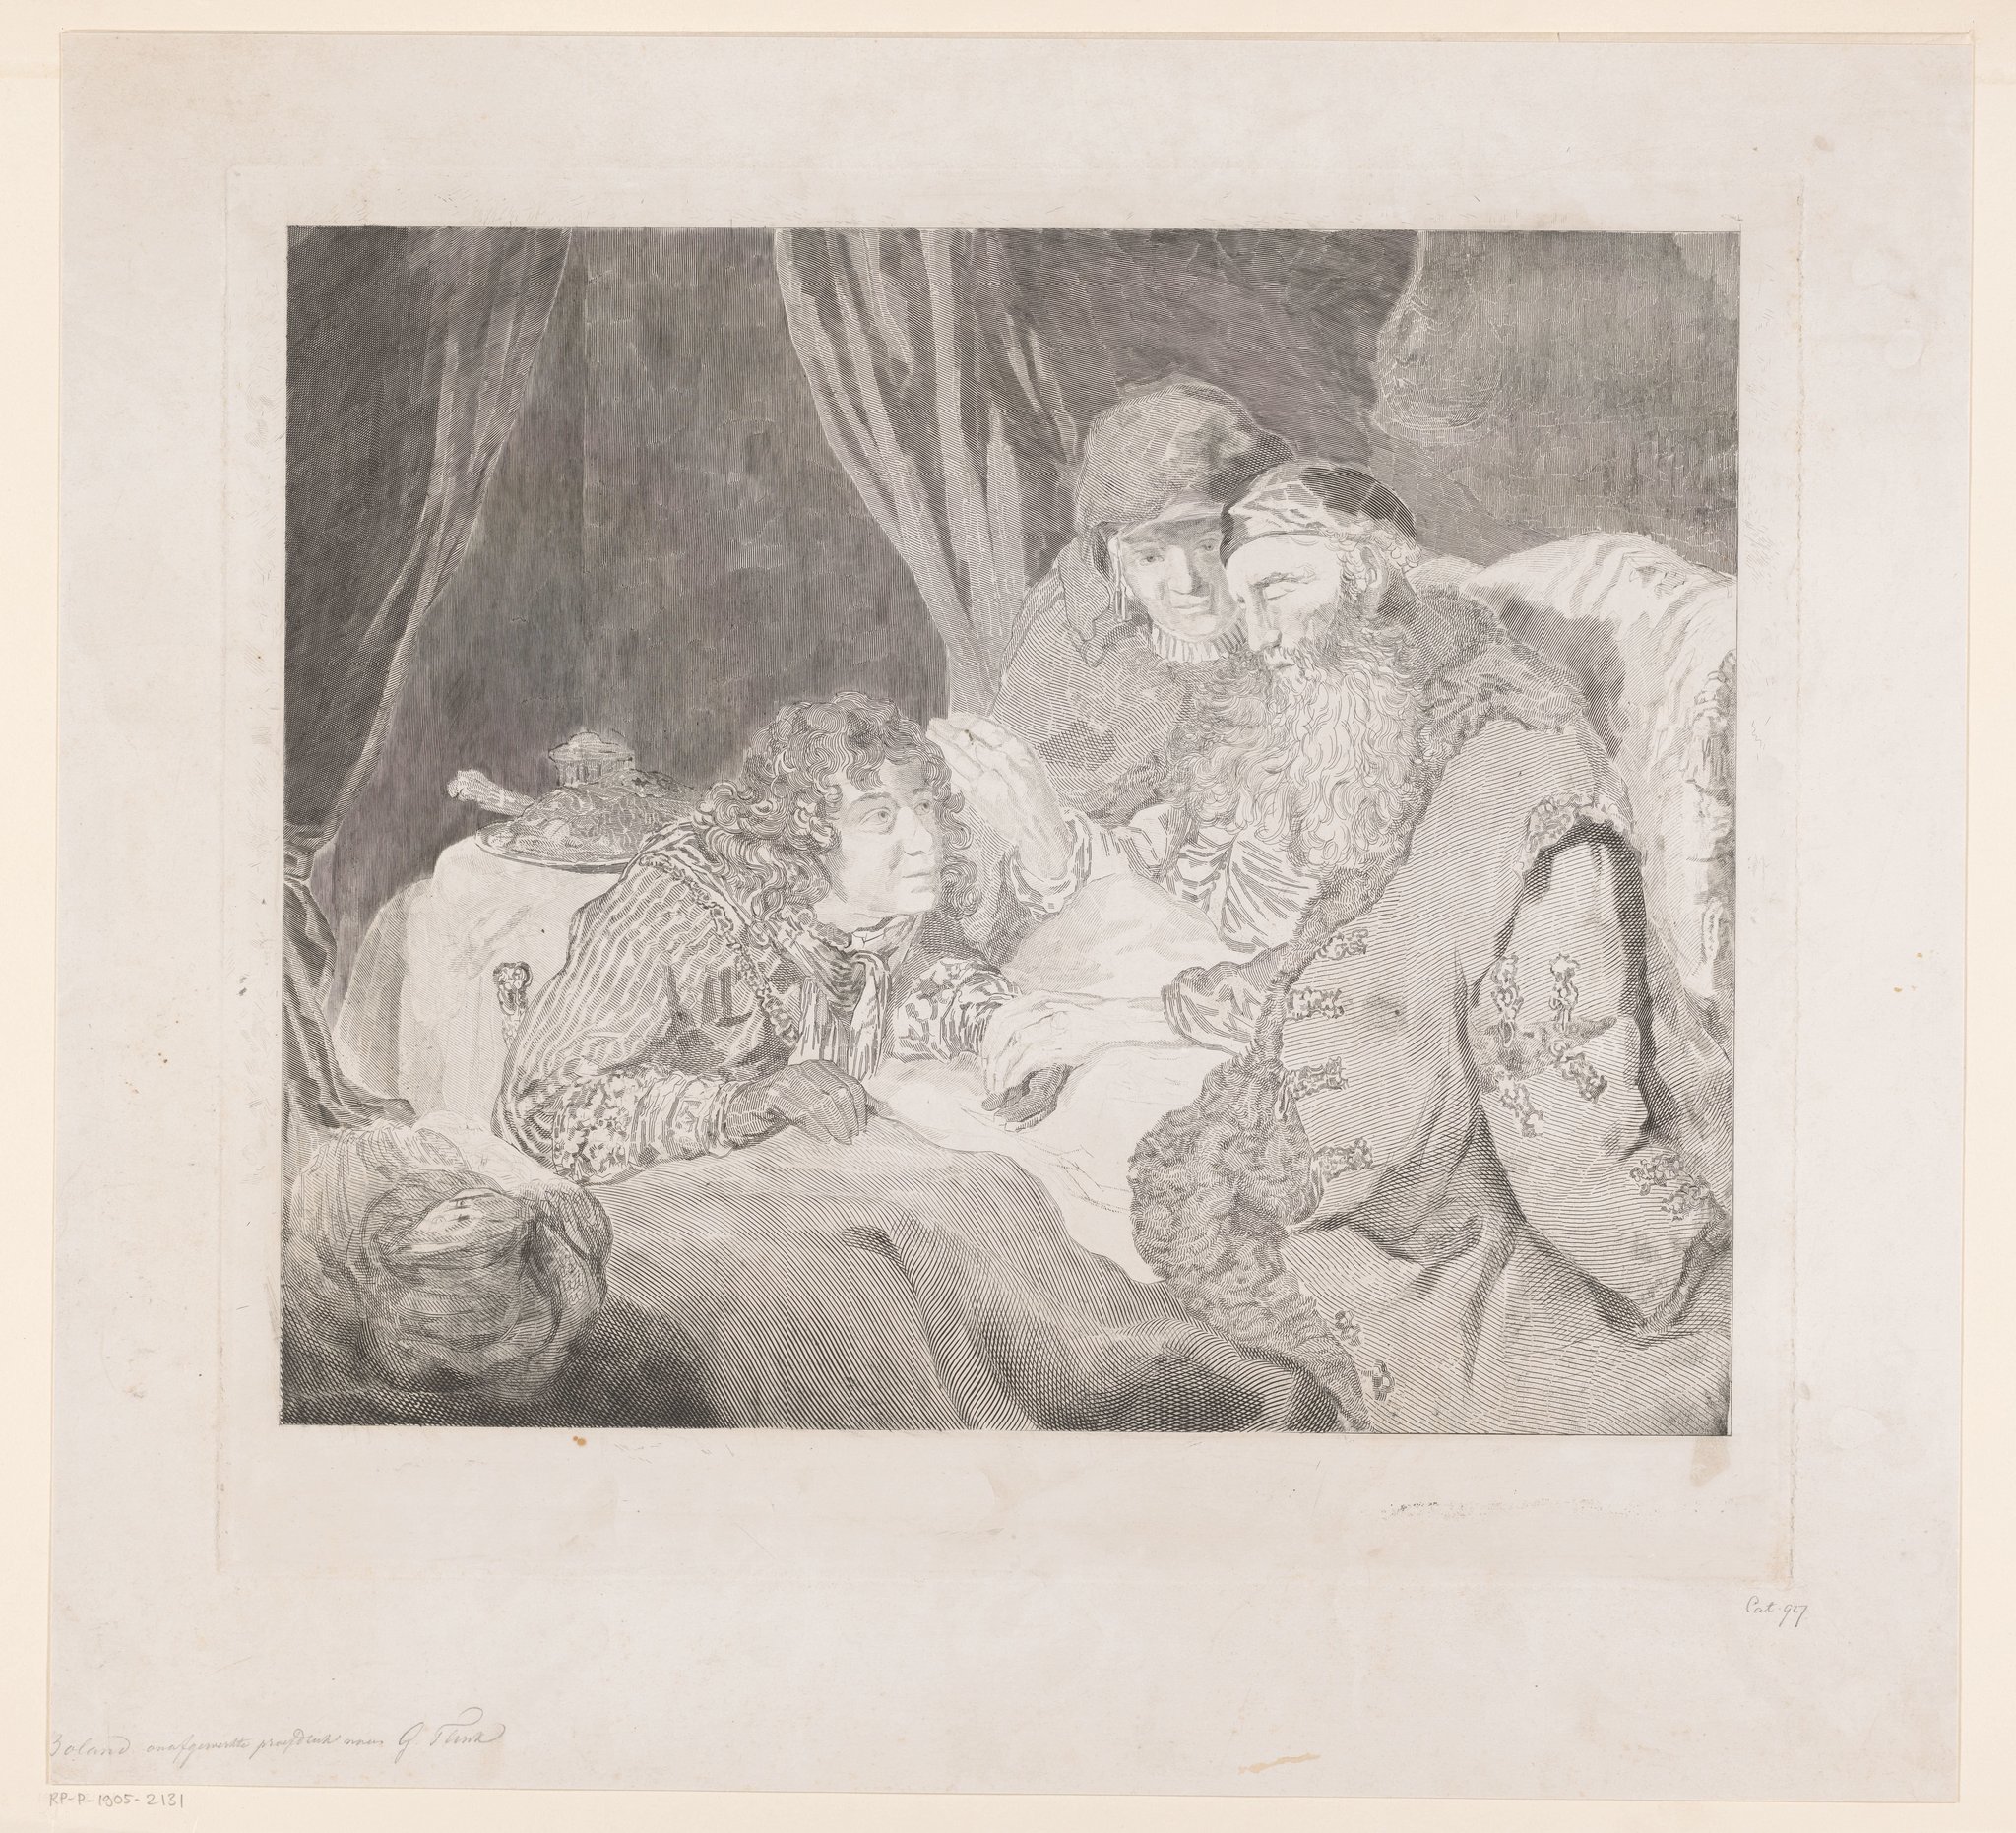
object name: print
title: Isaak zegent Jakob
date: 1860-1900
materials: paper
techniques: engraving, etching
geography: amsterdam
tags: jacob's visit to isaac ~ death of isaac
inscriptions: inscription: ‘Boland onafgewerkte proefdruk naar G. Flinck’, collector's mark: Lugt 2228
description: Isaak zegent Jakob. De oude Isaak zit in bed en geeft zijn zegen aan Jakob, rechts naast het bed staat Rebekka.